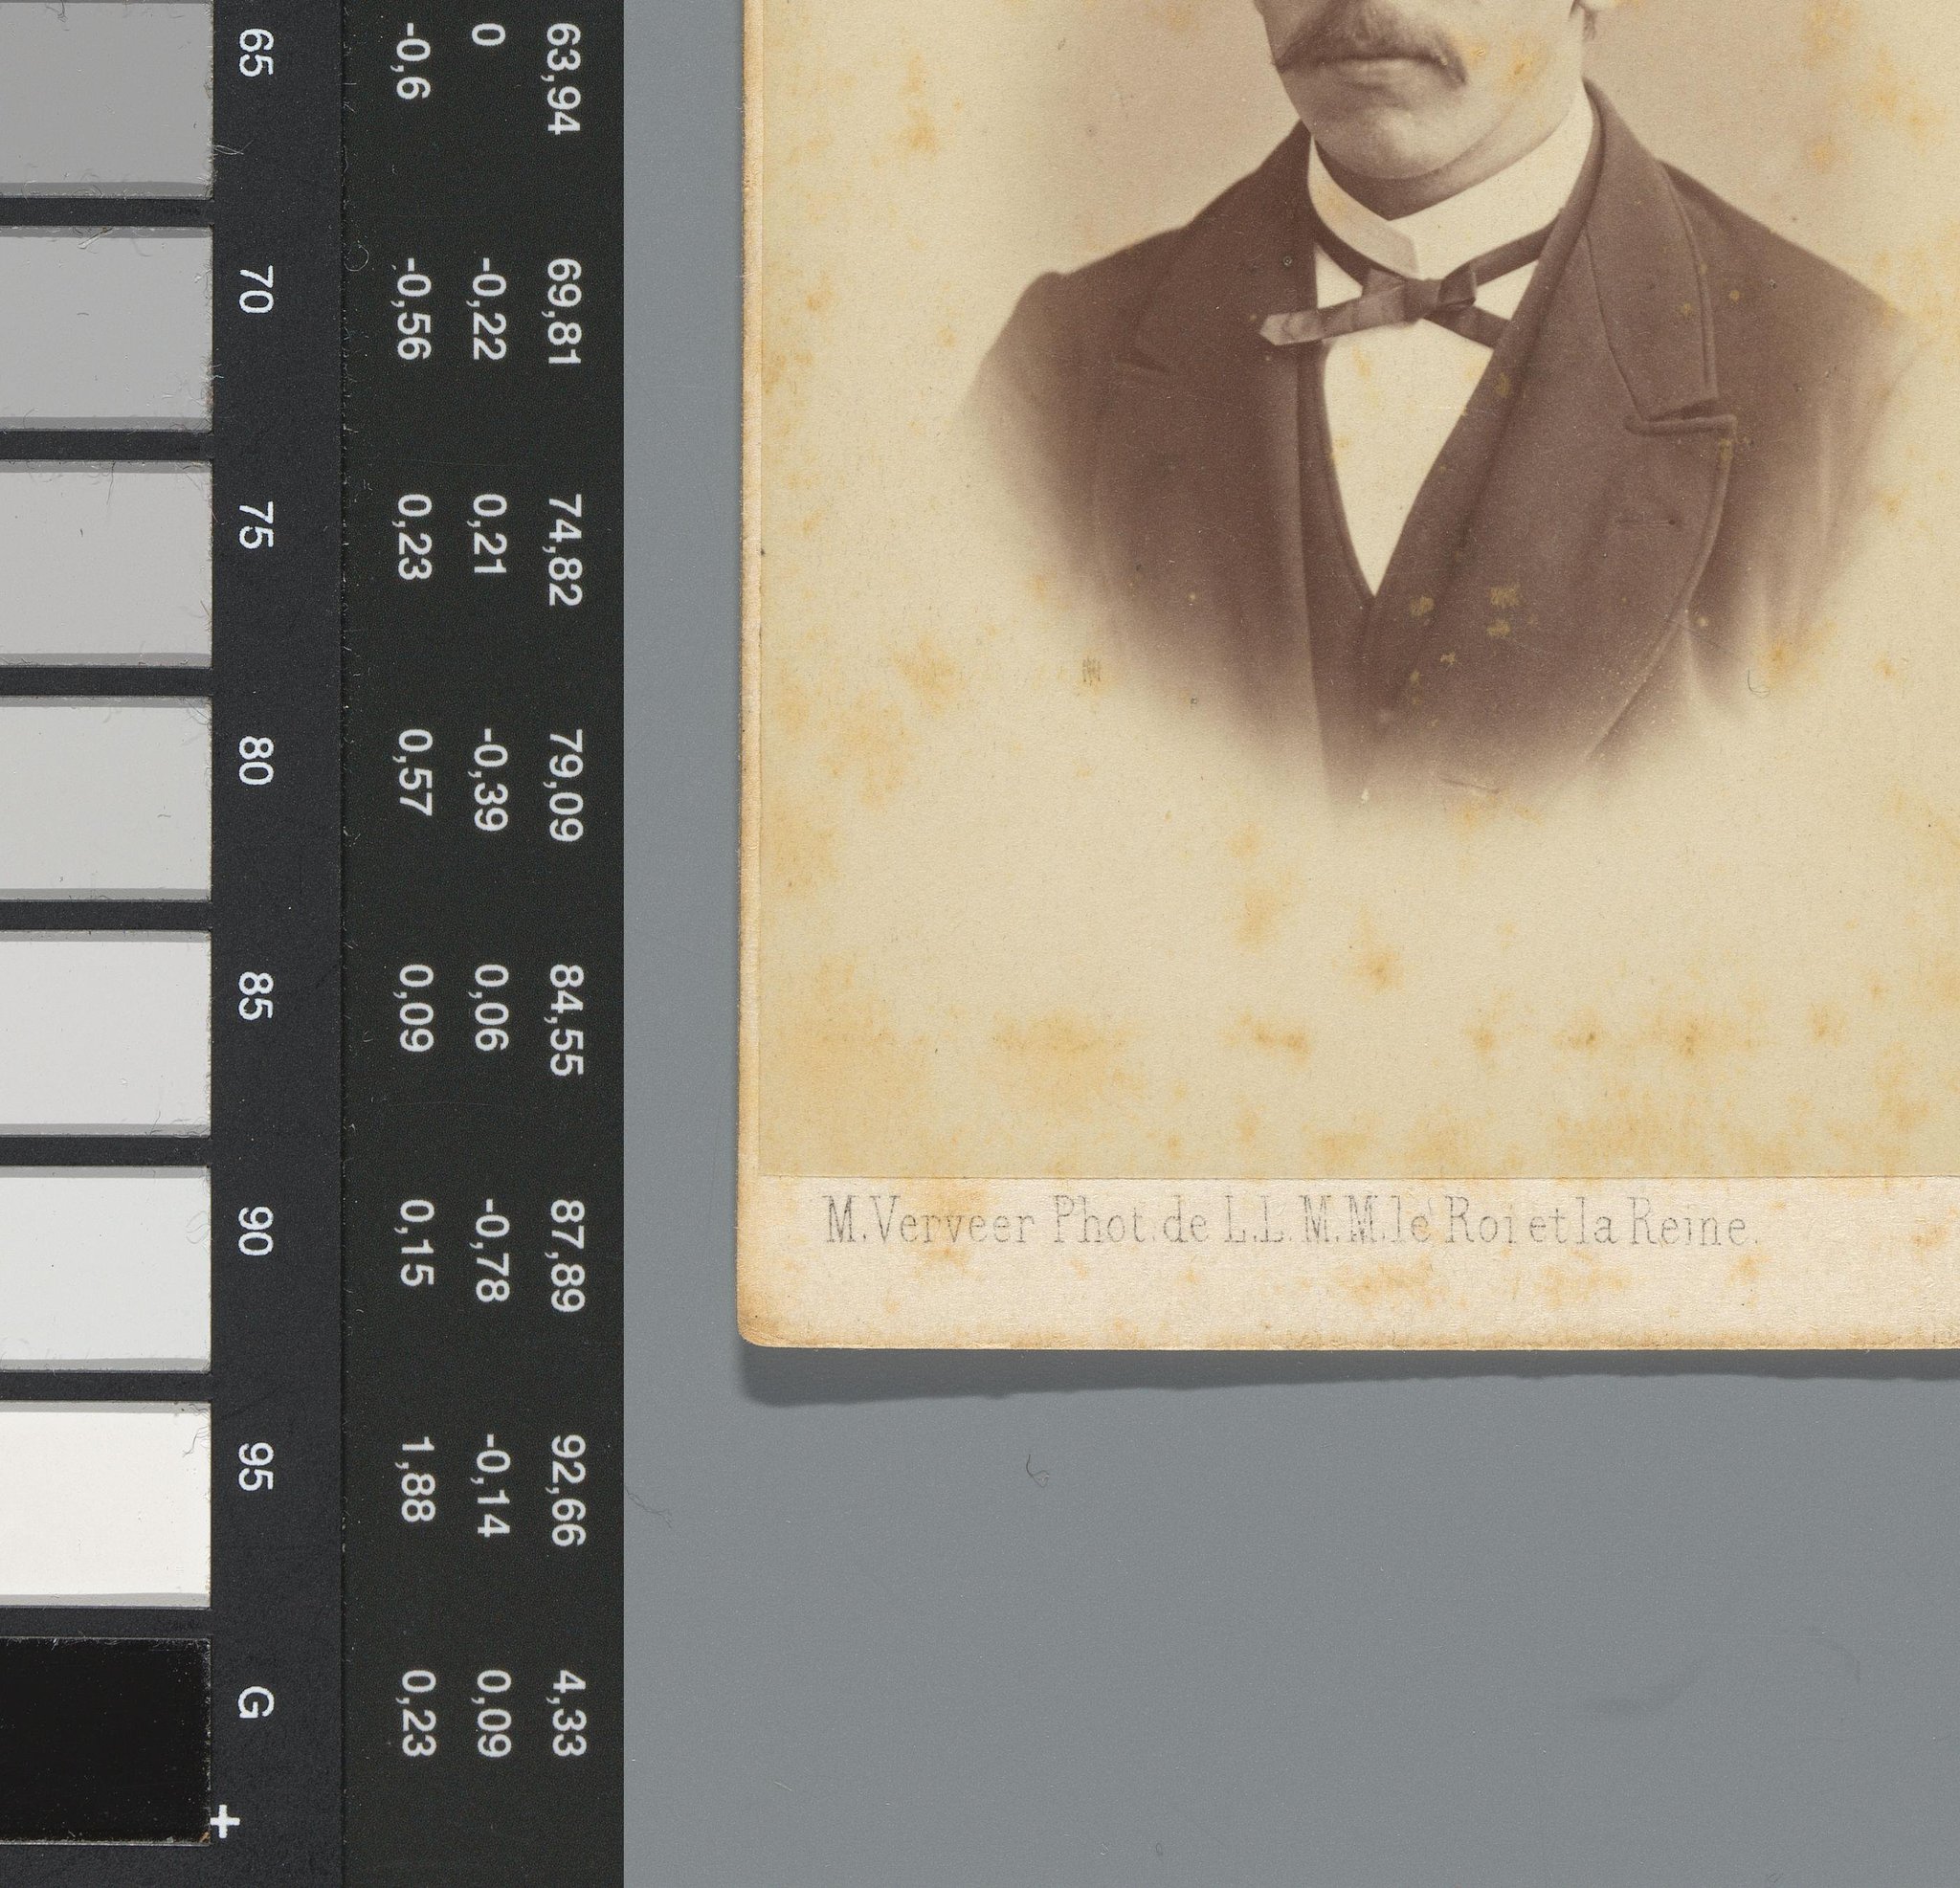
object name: carte de visite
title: Portret van Carolus Petrus van den Berg (Charles)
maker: maurits verveer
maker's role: painter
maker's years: 1817-1903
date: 1855-1910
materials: cardboard, photographic support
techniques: albumen print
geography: the hague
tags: rotterdam, utrecht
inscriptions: name: ‘M. Verveer Phot. de L.L.M.M. le Roi et la Reine’, inscription: ‘dit is Ooom / Charlie / Charles / van den Berg / 1840 - / 1881’, name: ‘M. VERVEER / Photographe / de L.L.M.M. le Roi et la Reine des Pays-Bas / 52 ZEESTRAAT 52 / VIS A VIS DU WILLEMSPARK / LA HAYE’